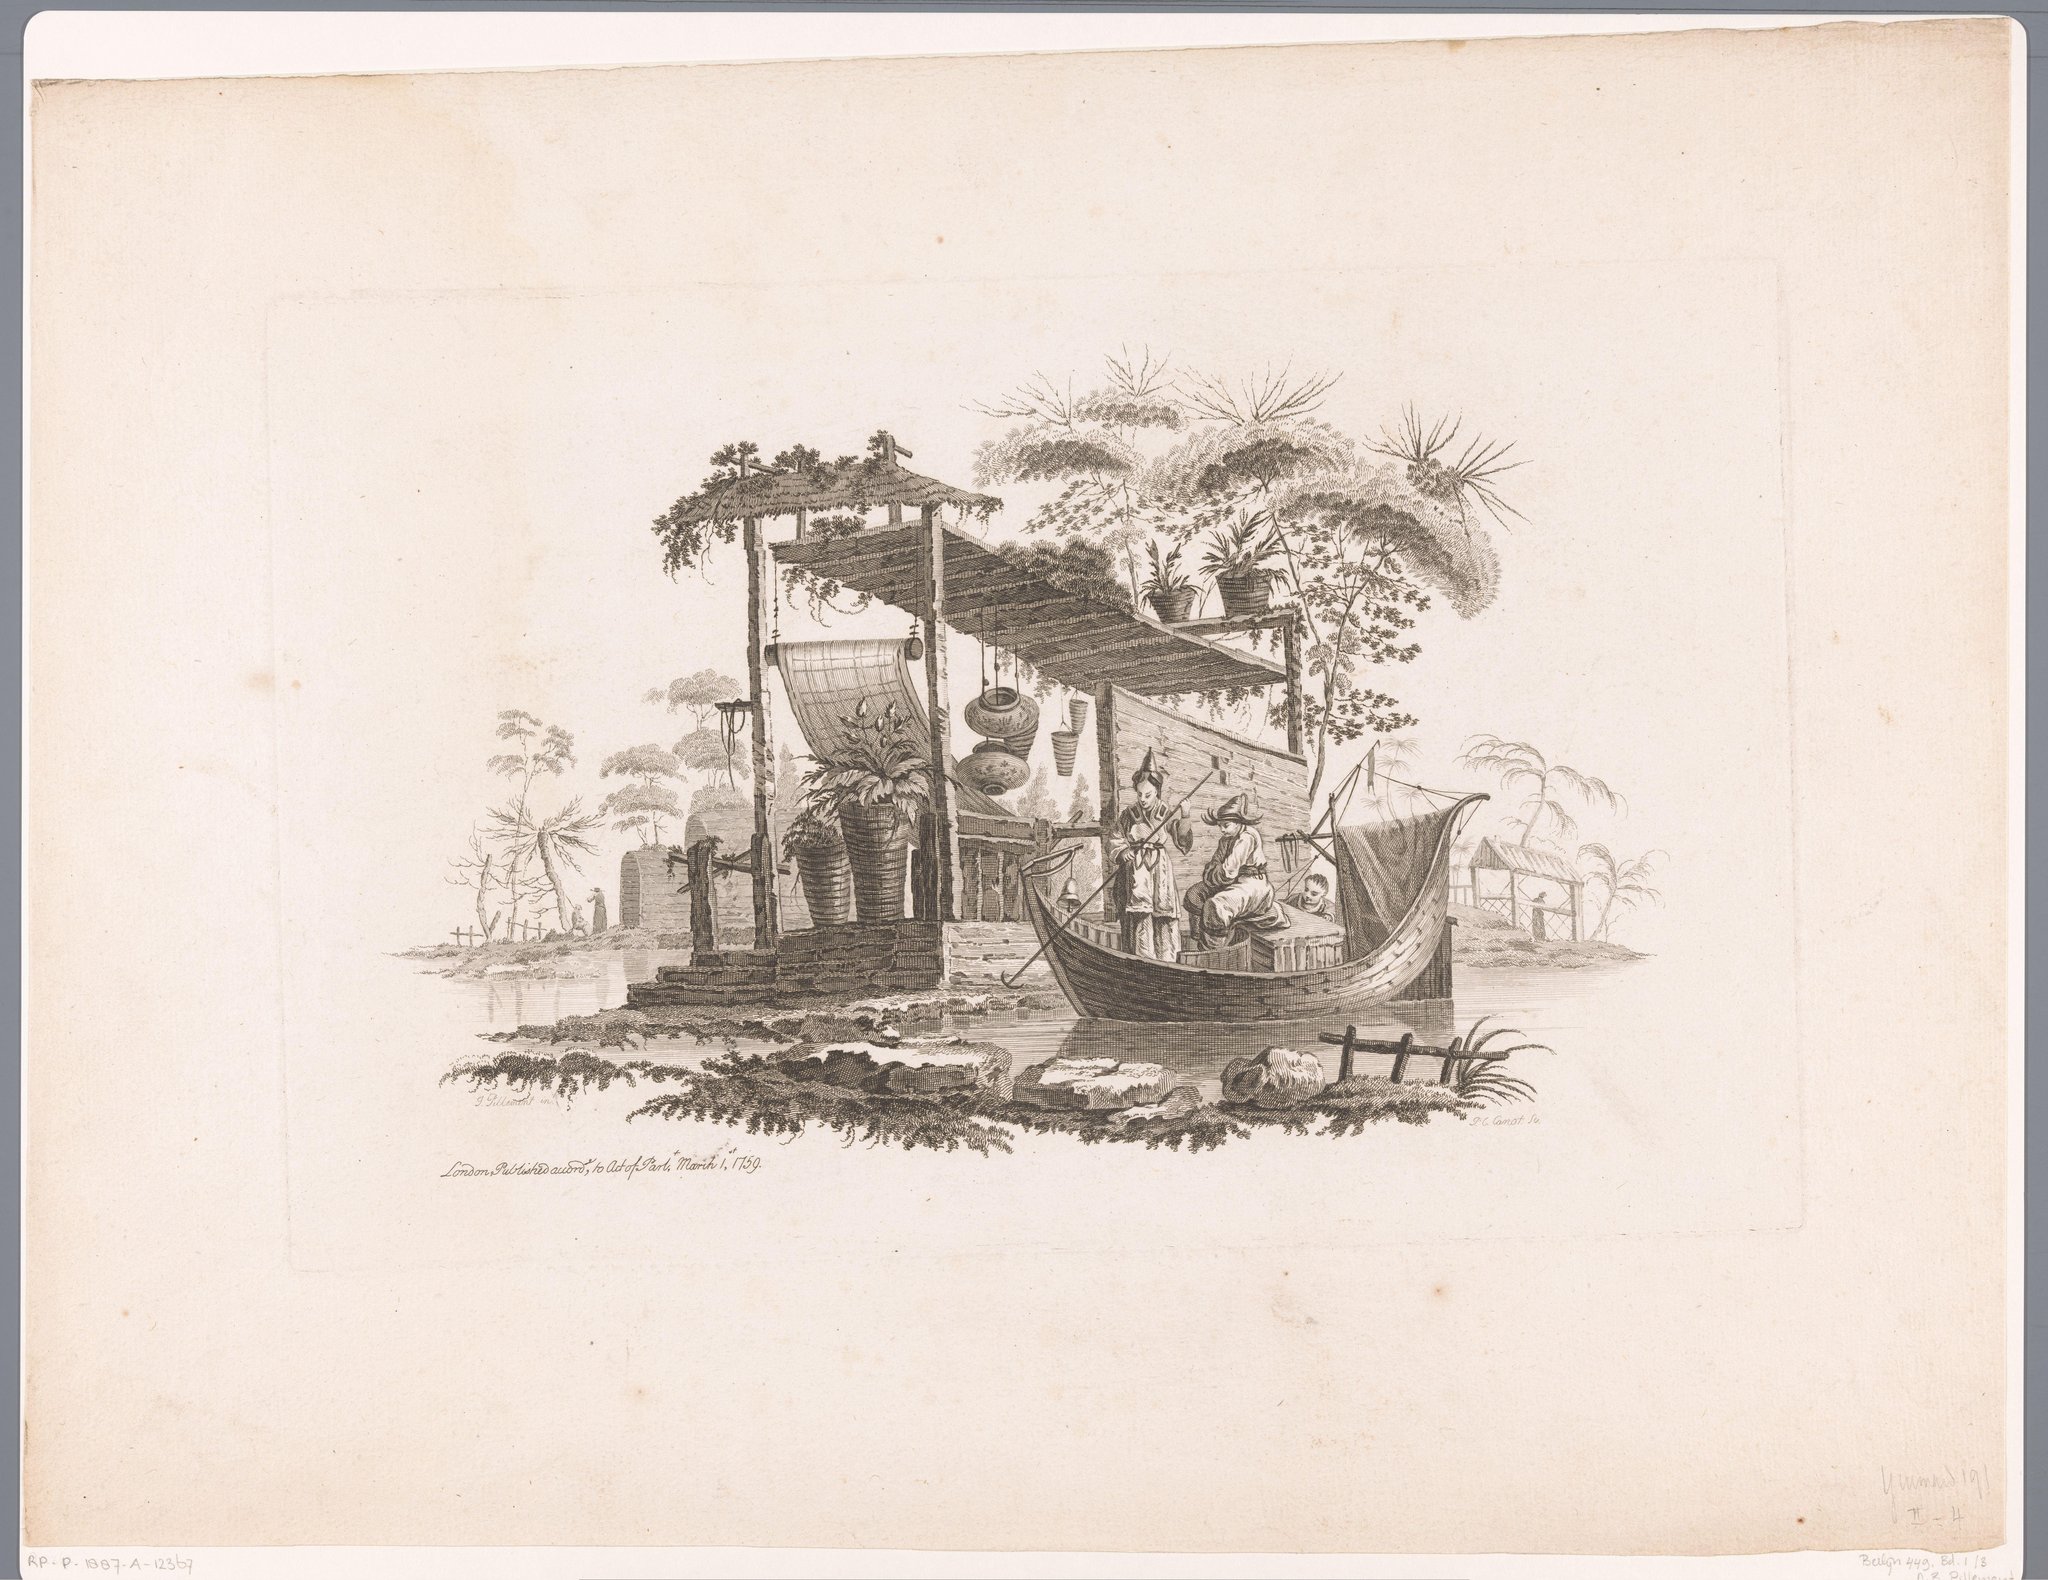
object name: print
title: Chinese genrestukken in landschappen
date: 1759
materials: paper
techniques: etching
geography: london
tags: boat propelled by man or animal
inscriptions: collector's mark: Lugt 2228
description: Drie Chinese figuren op een boot meren aan bij een afdak op een oever. Onder het afdak hangen lampionnen en staan vazen.